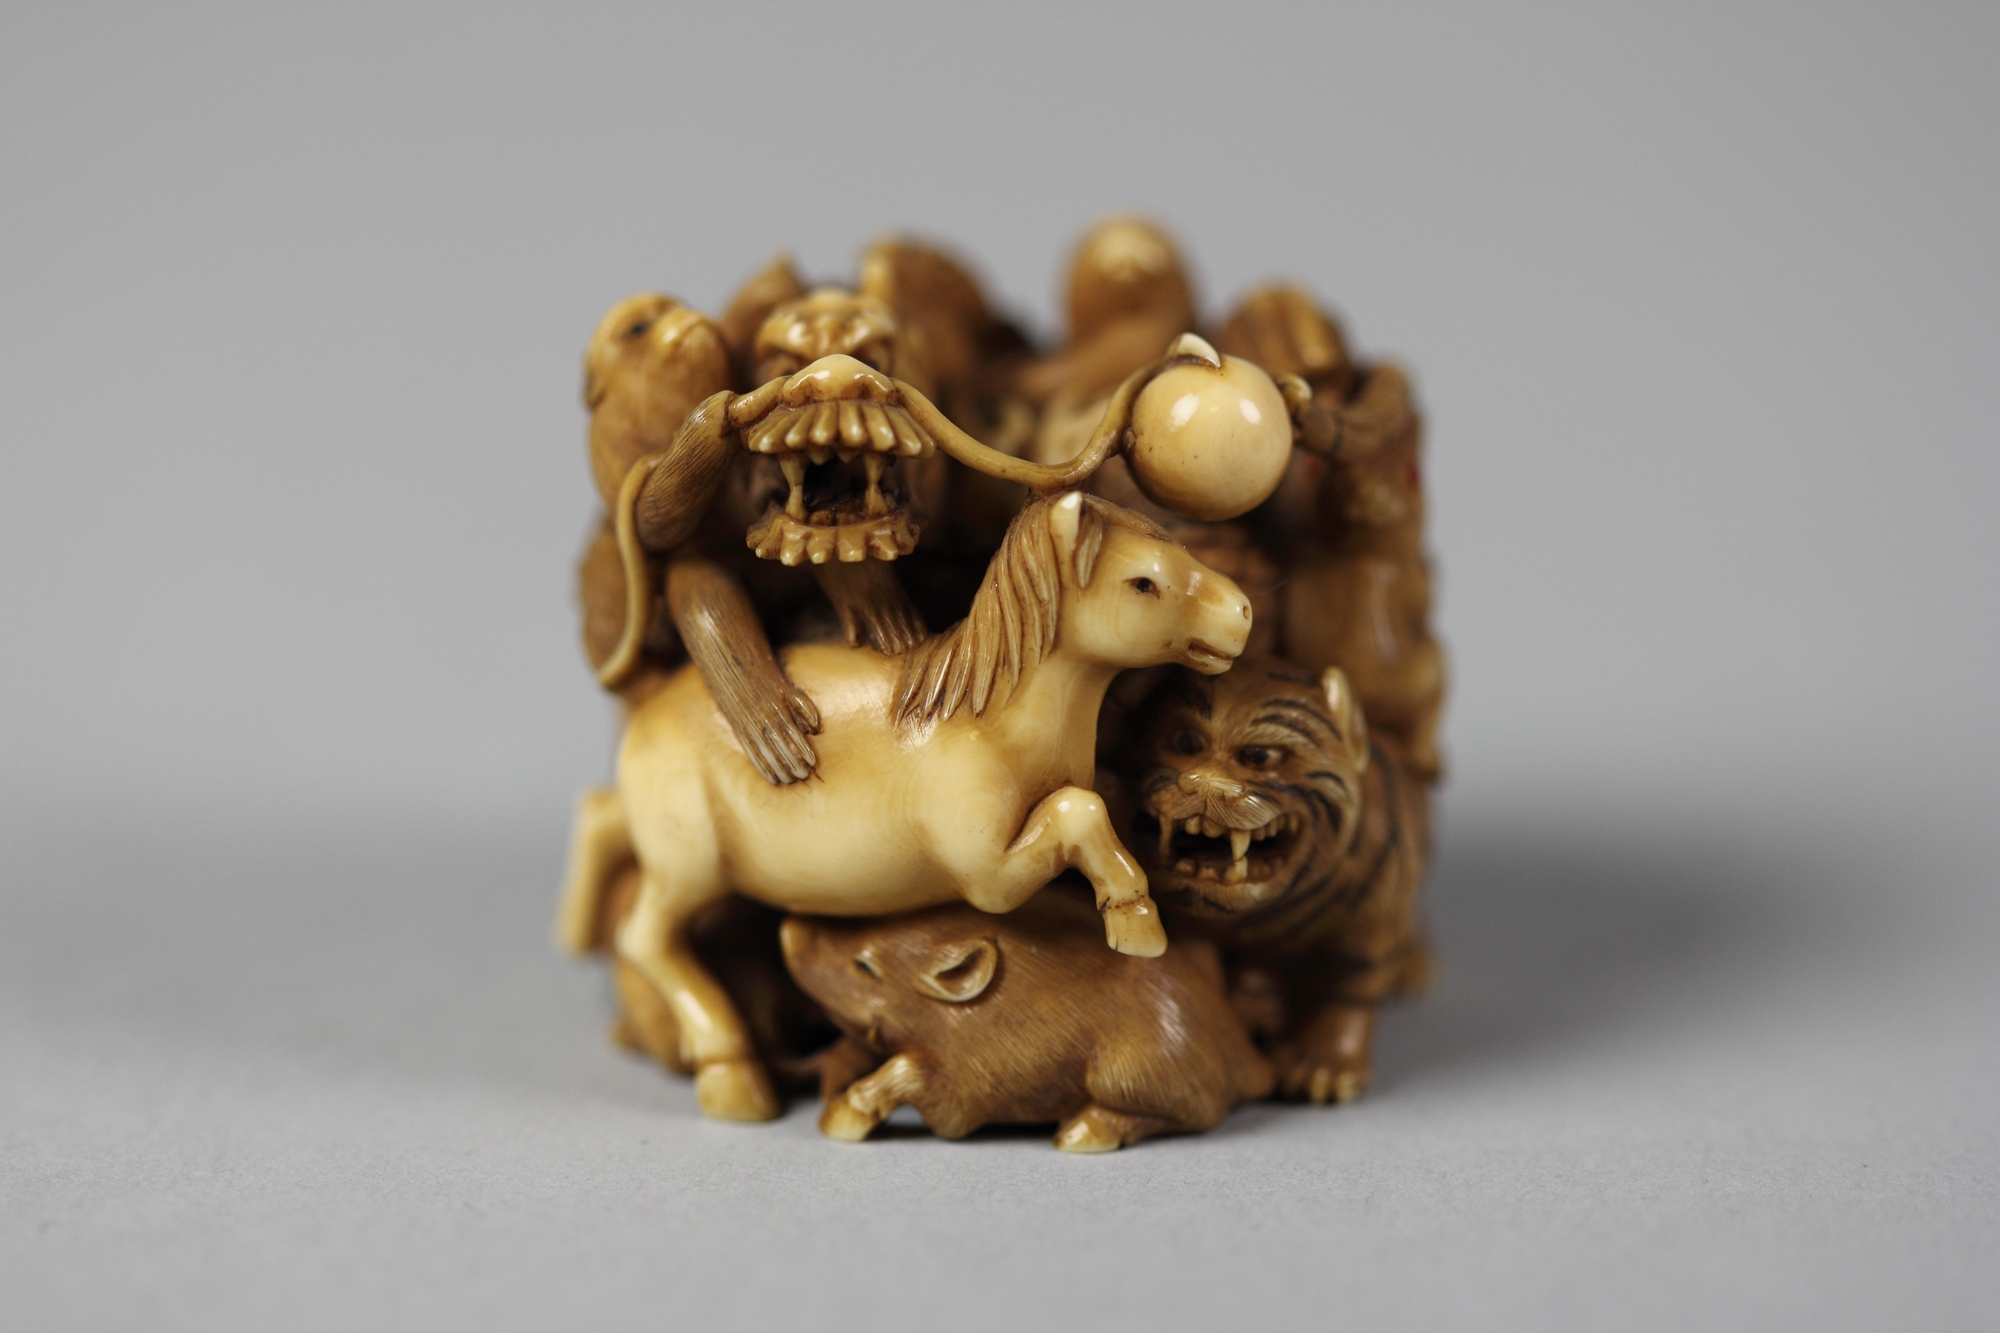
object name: netsuke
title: Netsuke of Group of Animals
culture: japanese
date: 1801-1900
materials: ivory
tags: dragons,boars,rabbits,tigers